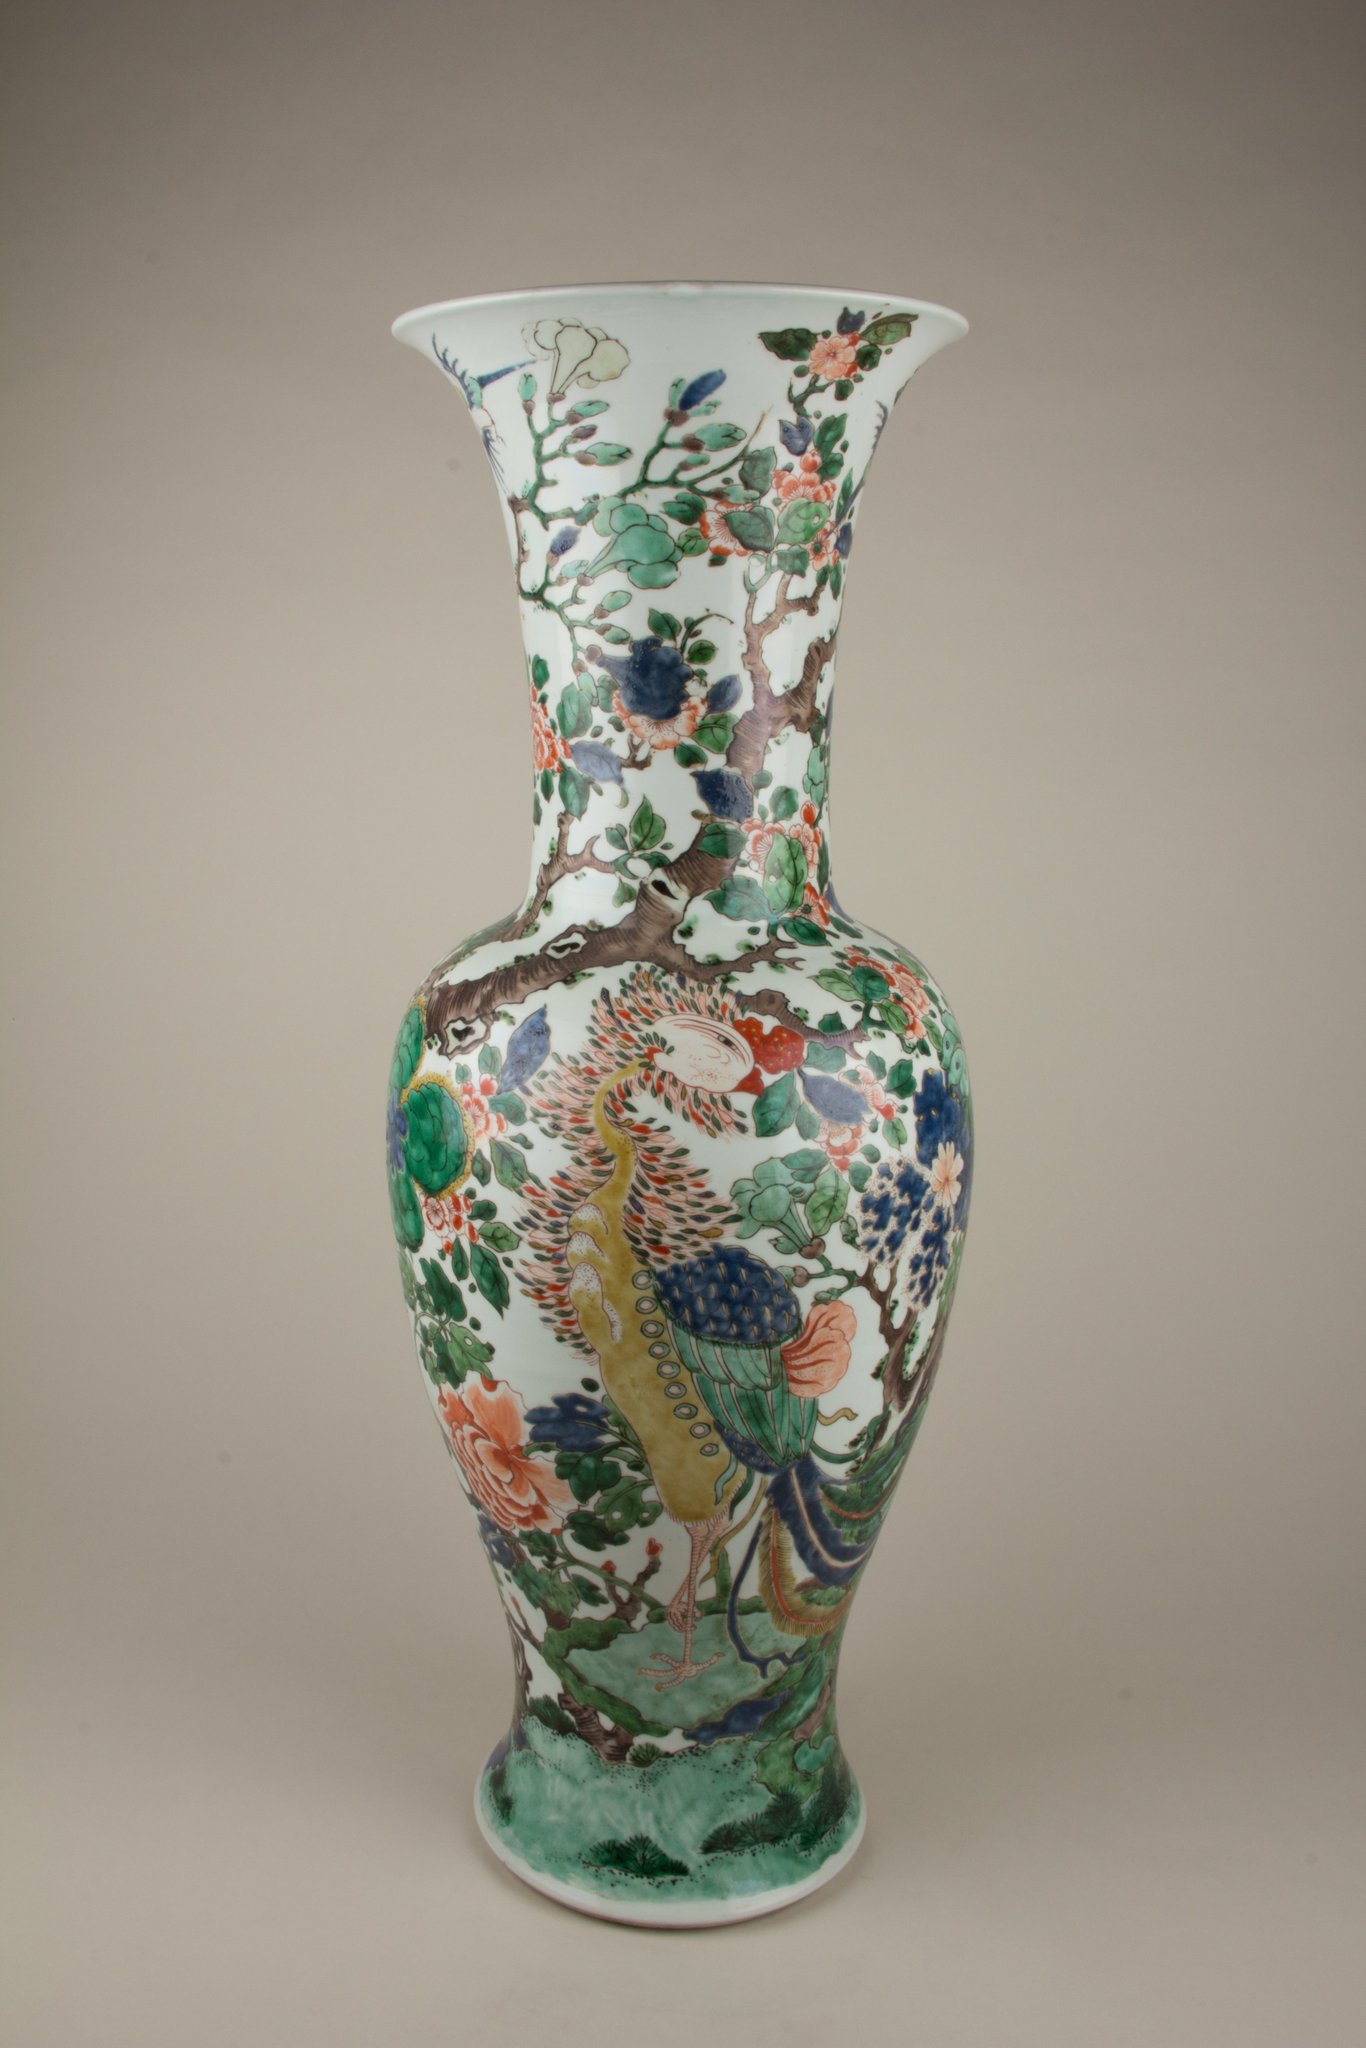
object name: vase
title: Vase with birds and flowers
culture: chinese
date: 1667-1733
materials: enamel, porcelain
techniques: overglaze, painting, polychrome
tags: birds,flowers,leaves,trees